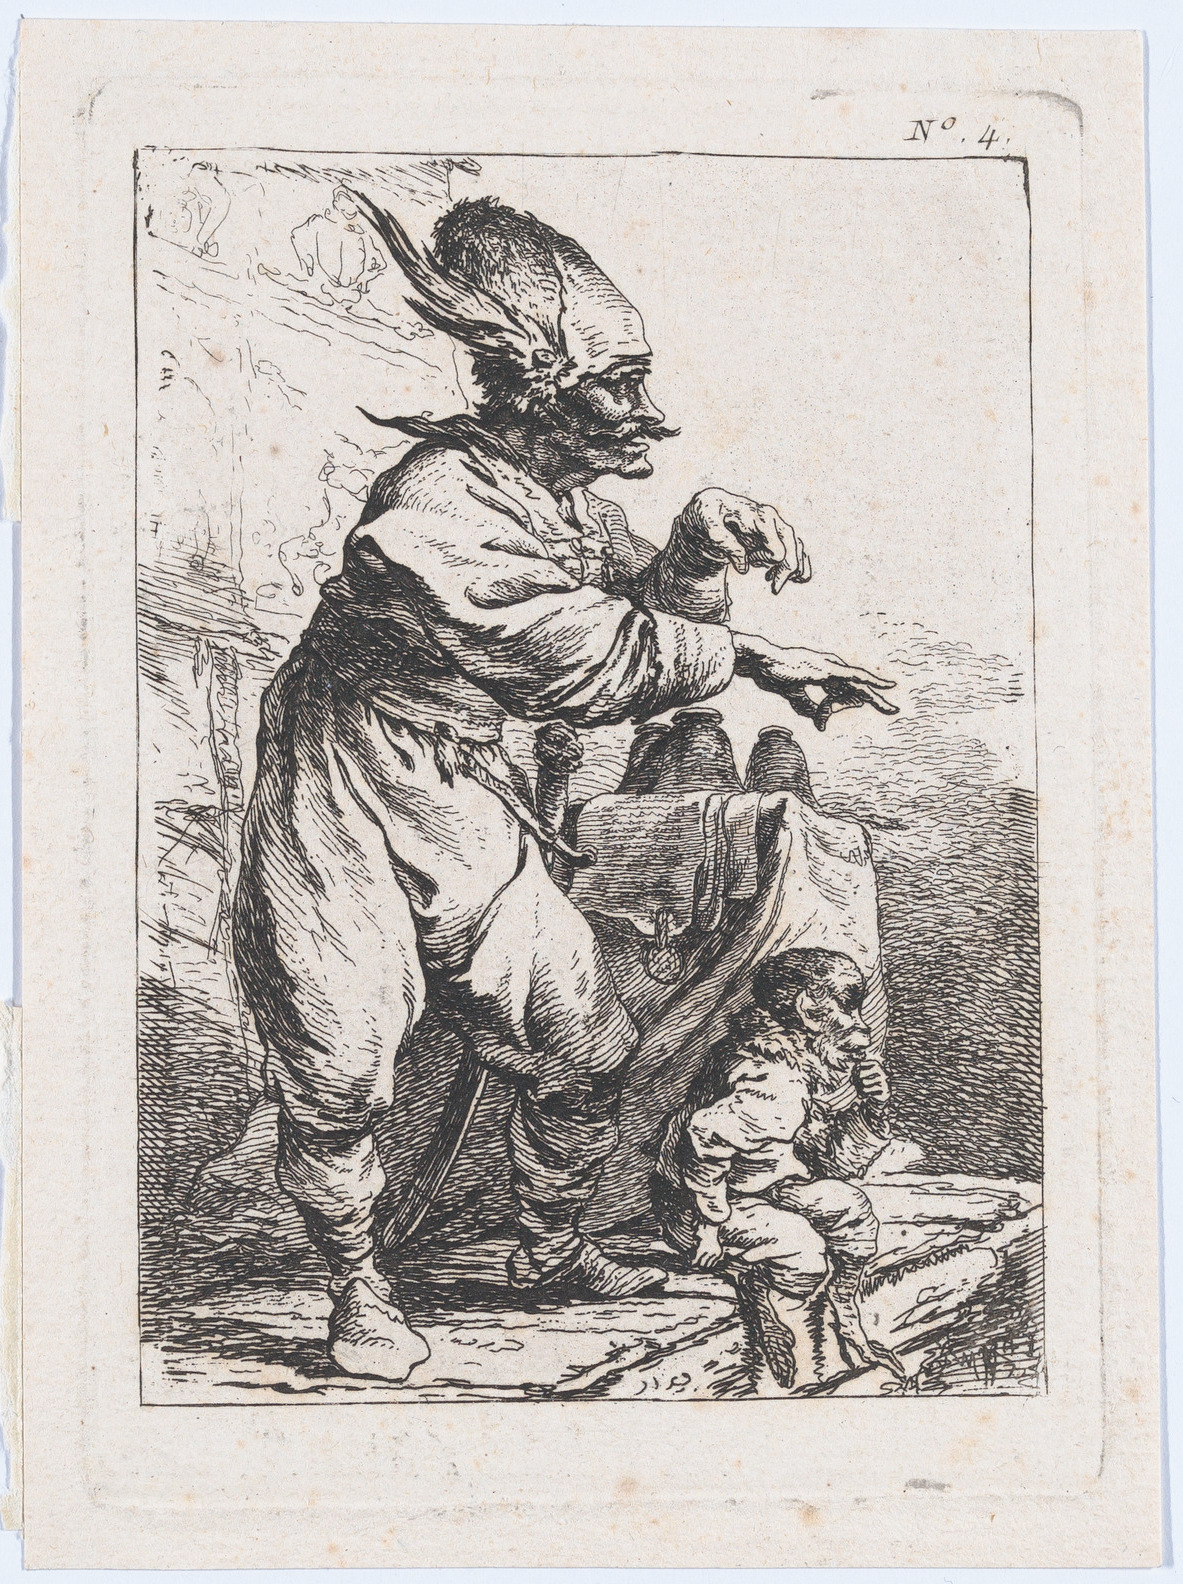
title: A Performer on a Stage with a Monkey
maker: philippe jacques de loutherbourg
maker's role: artist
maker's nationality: french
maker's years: 1740-1812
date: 1755-1771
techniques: etching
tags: performance,men,monkeys